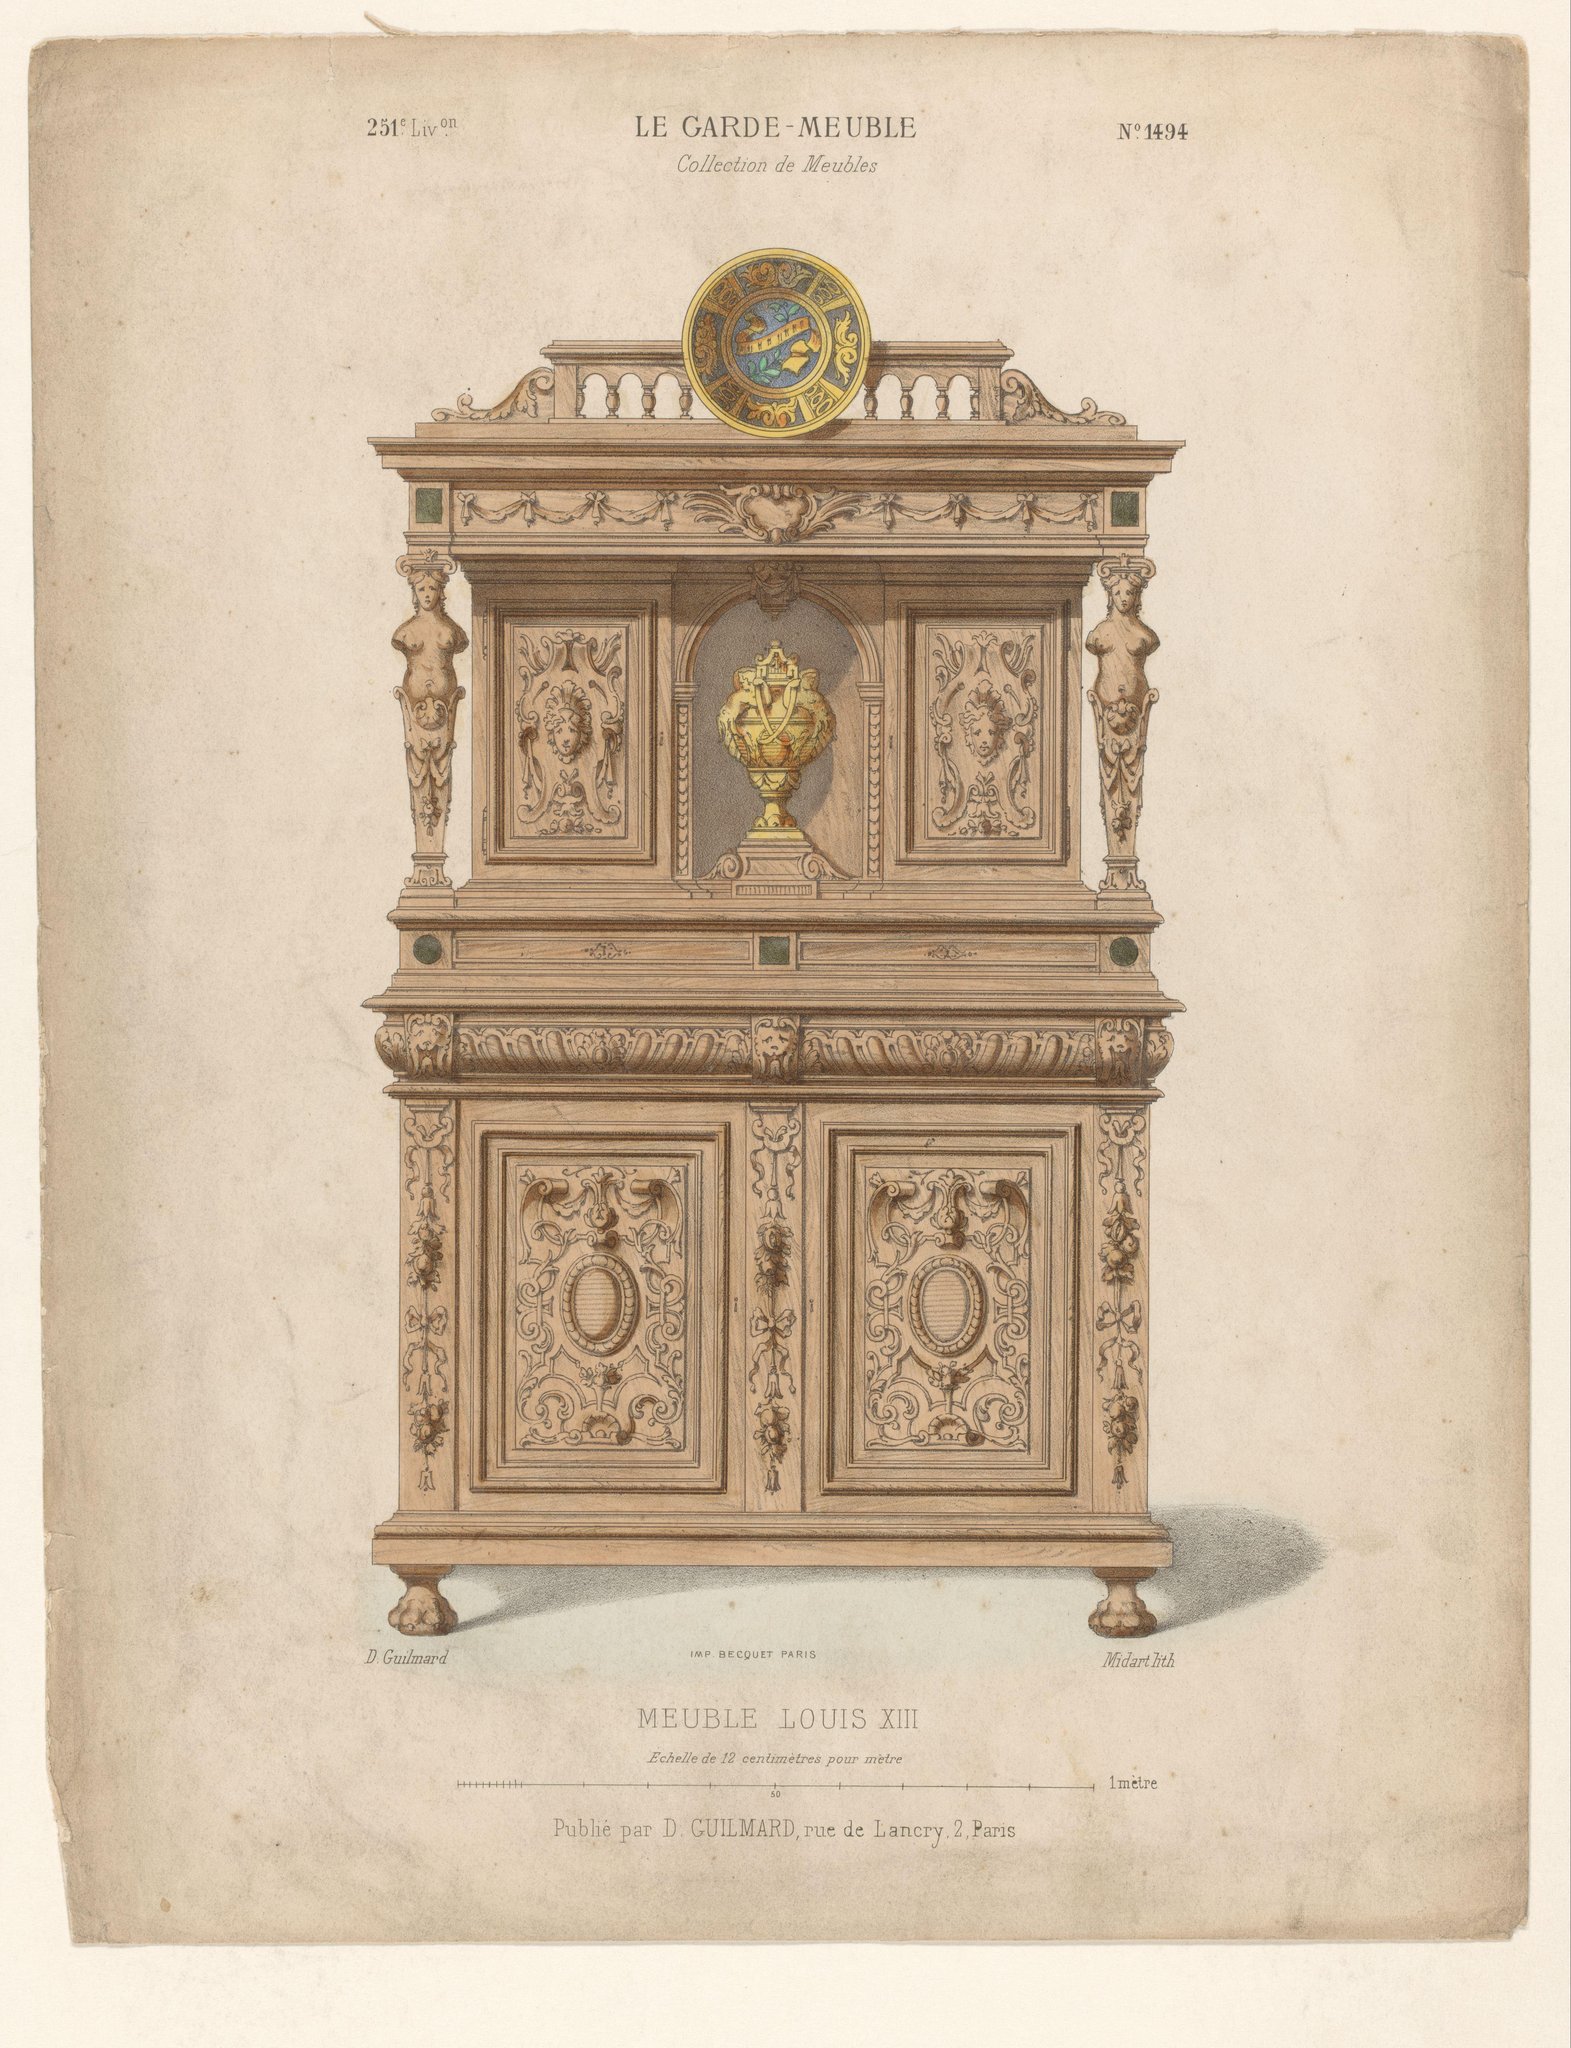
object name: print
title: Kast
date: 1839-1885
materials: paper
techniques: hand coloring, lithograph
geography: paris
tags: furniture for storage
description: Ieder Livraison in de serie Le Garde-Meuble bevat negen platen: drie 'sièges' (zitmeubels), drie 'meubles' (diverse meubels zoals tafels en kasten) en drie 'tentures' (gordijnen en draperieën).